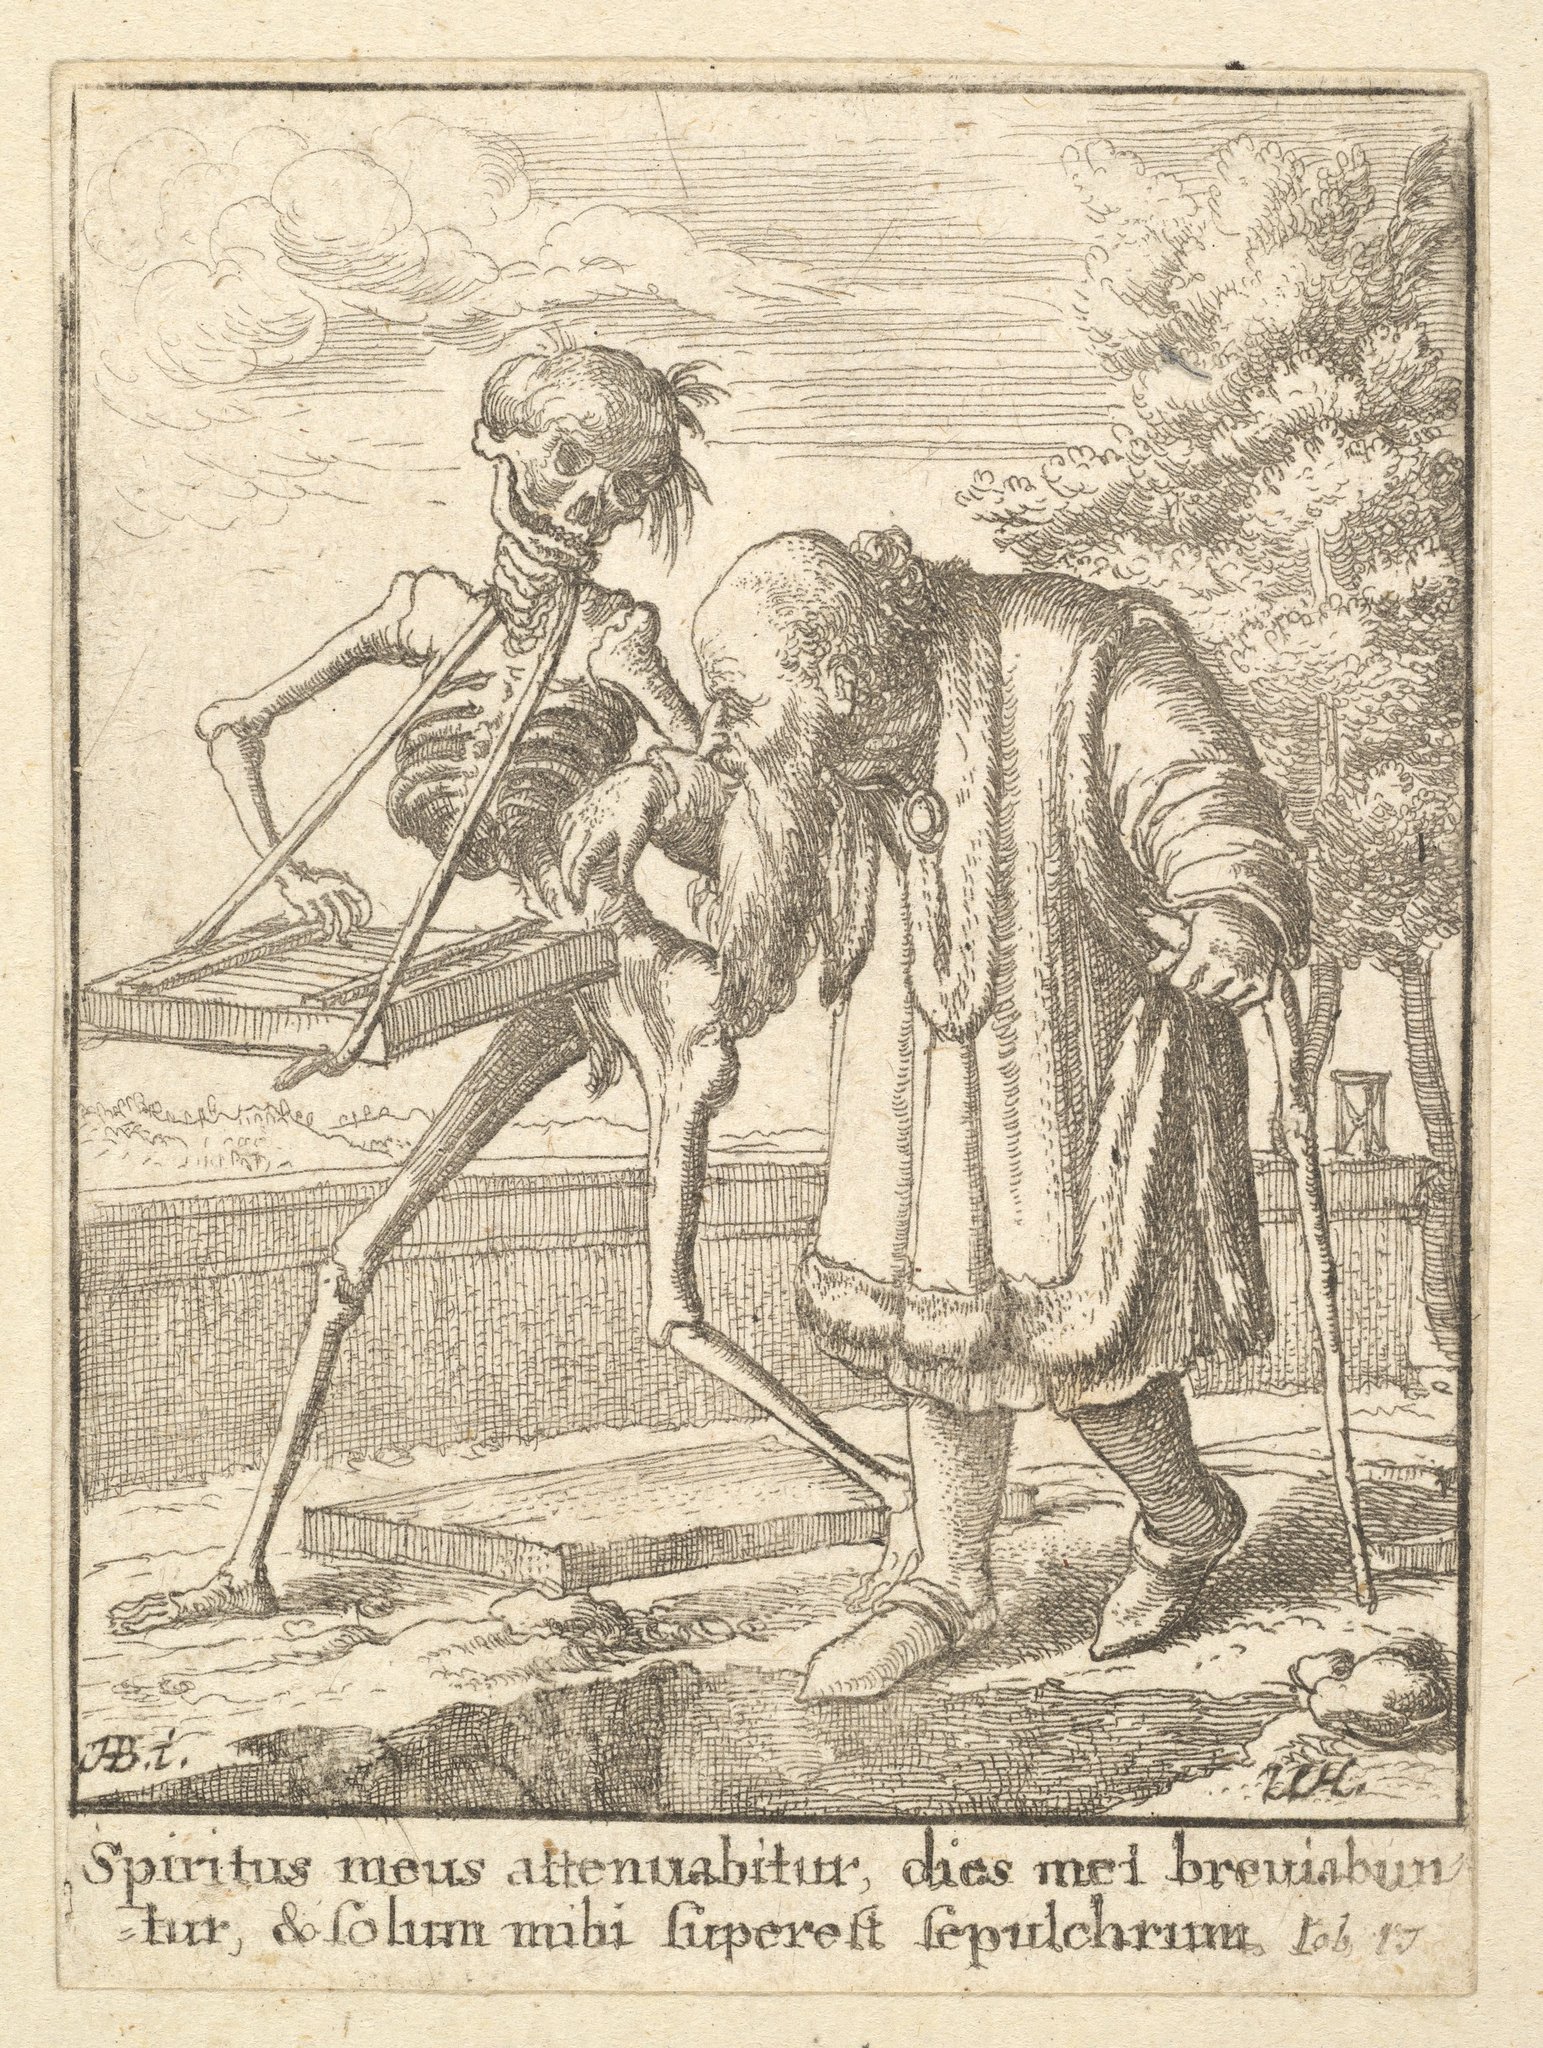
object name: print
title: Old man, from the Dance of Death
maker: wenceslaus hollar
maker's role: artist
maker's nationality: bohemian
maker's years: 1607-1677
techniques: etching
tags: skeletons,men